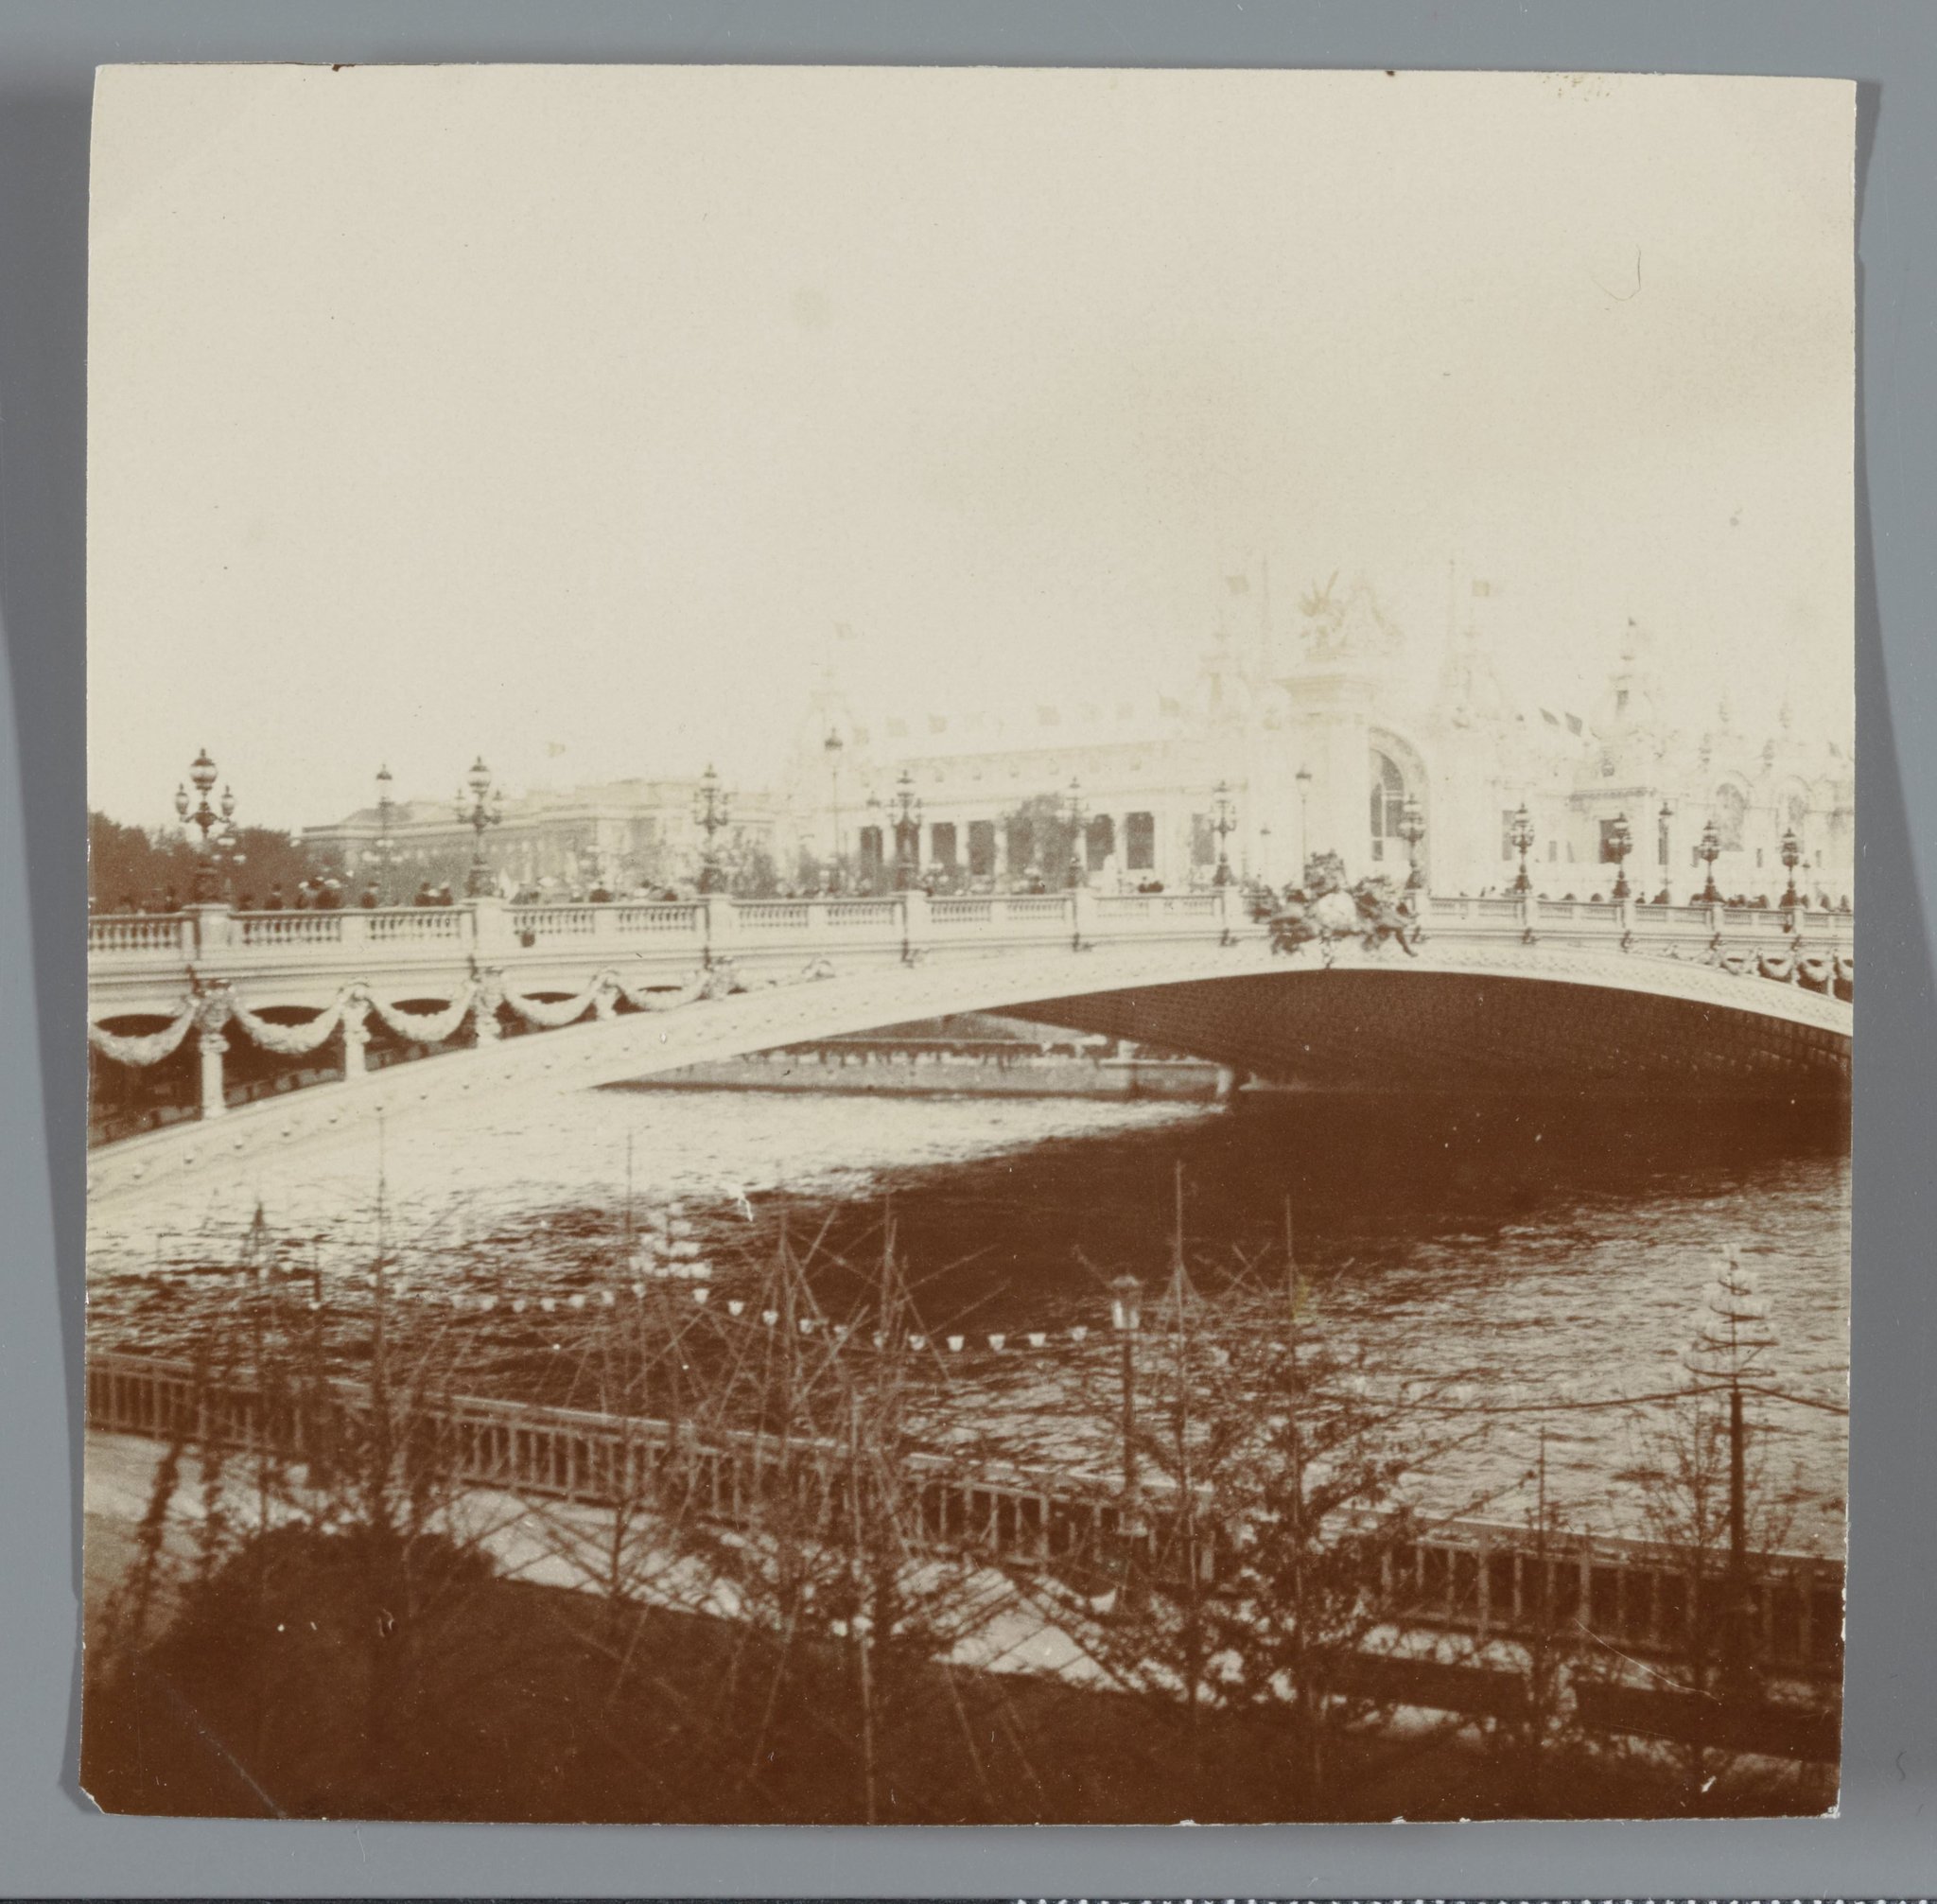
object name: photograph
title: Pont Alexandre III en Palais des Manufactures Nationales, Exposition Universelle (Wereldtentoonstelling), Parijs, Frankrijk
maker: Anonymous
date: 1900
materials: paper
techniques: gelatin silver print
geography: france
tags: world fair, world exhibition, bridge, france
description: Pont Alexandre III en Palais des Manufactures Nationales, Exposition Universelle (Wereldtentoonstelling), Parijs, Frankrijk.